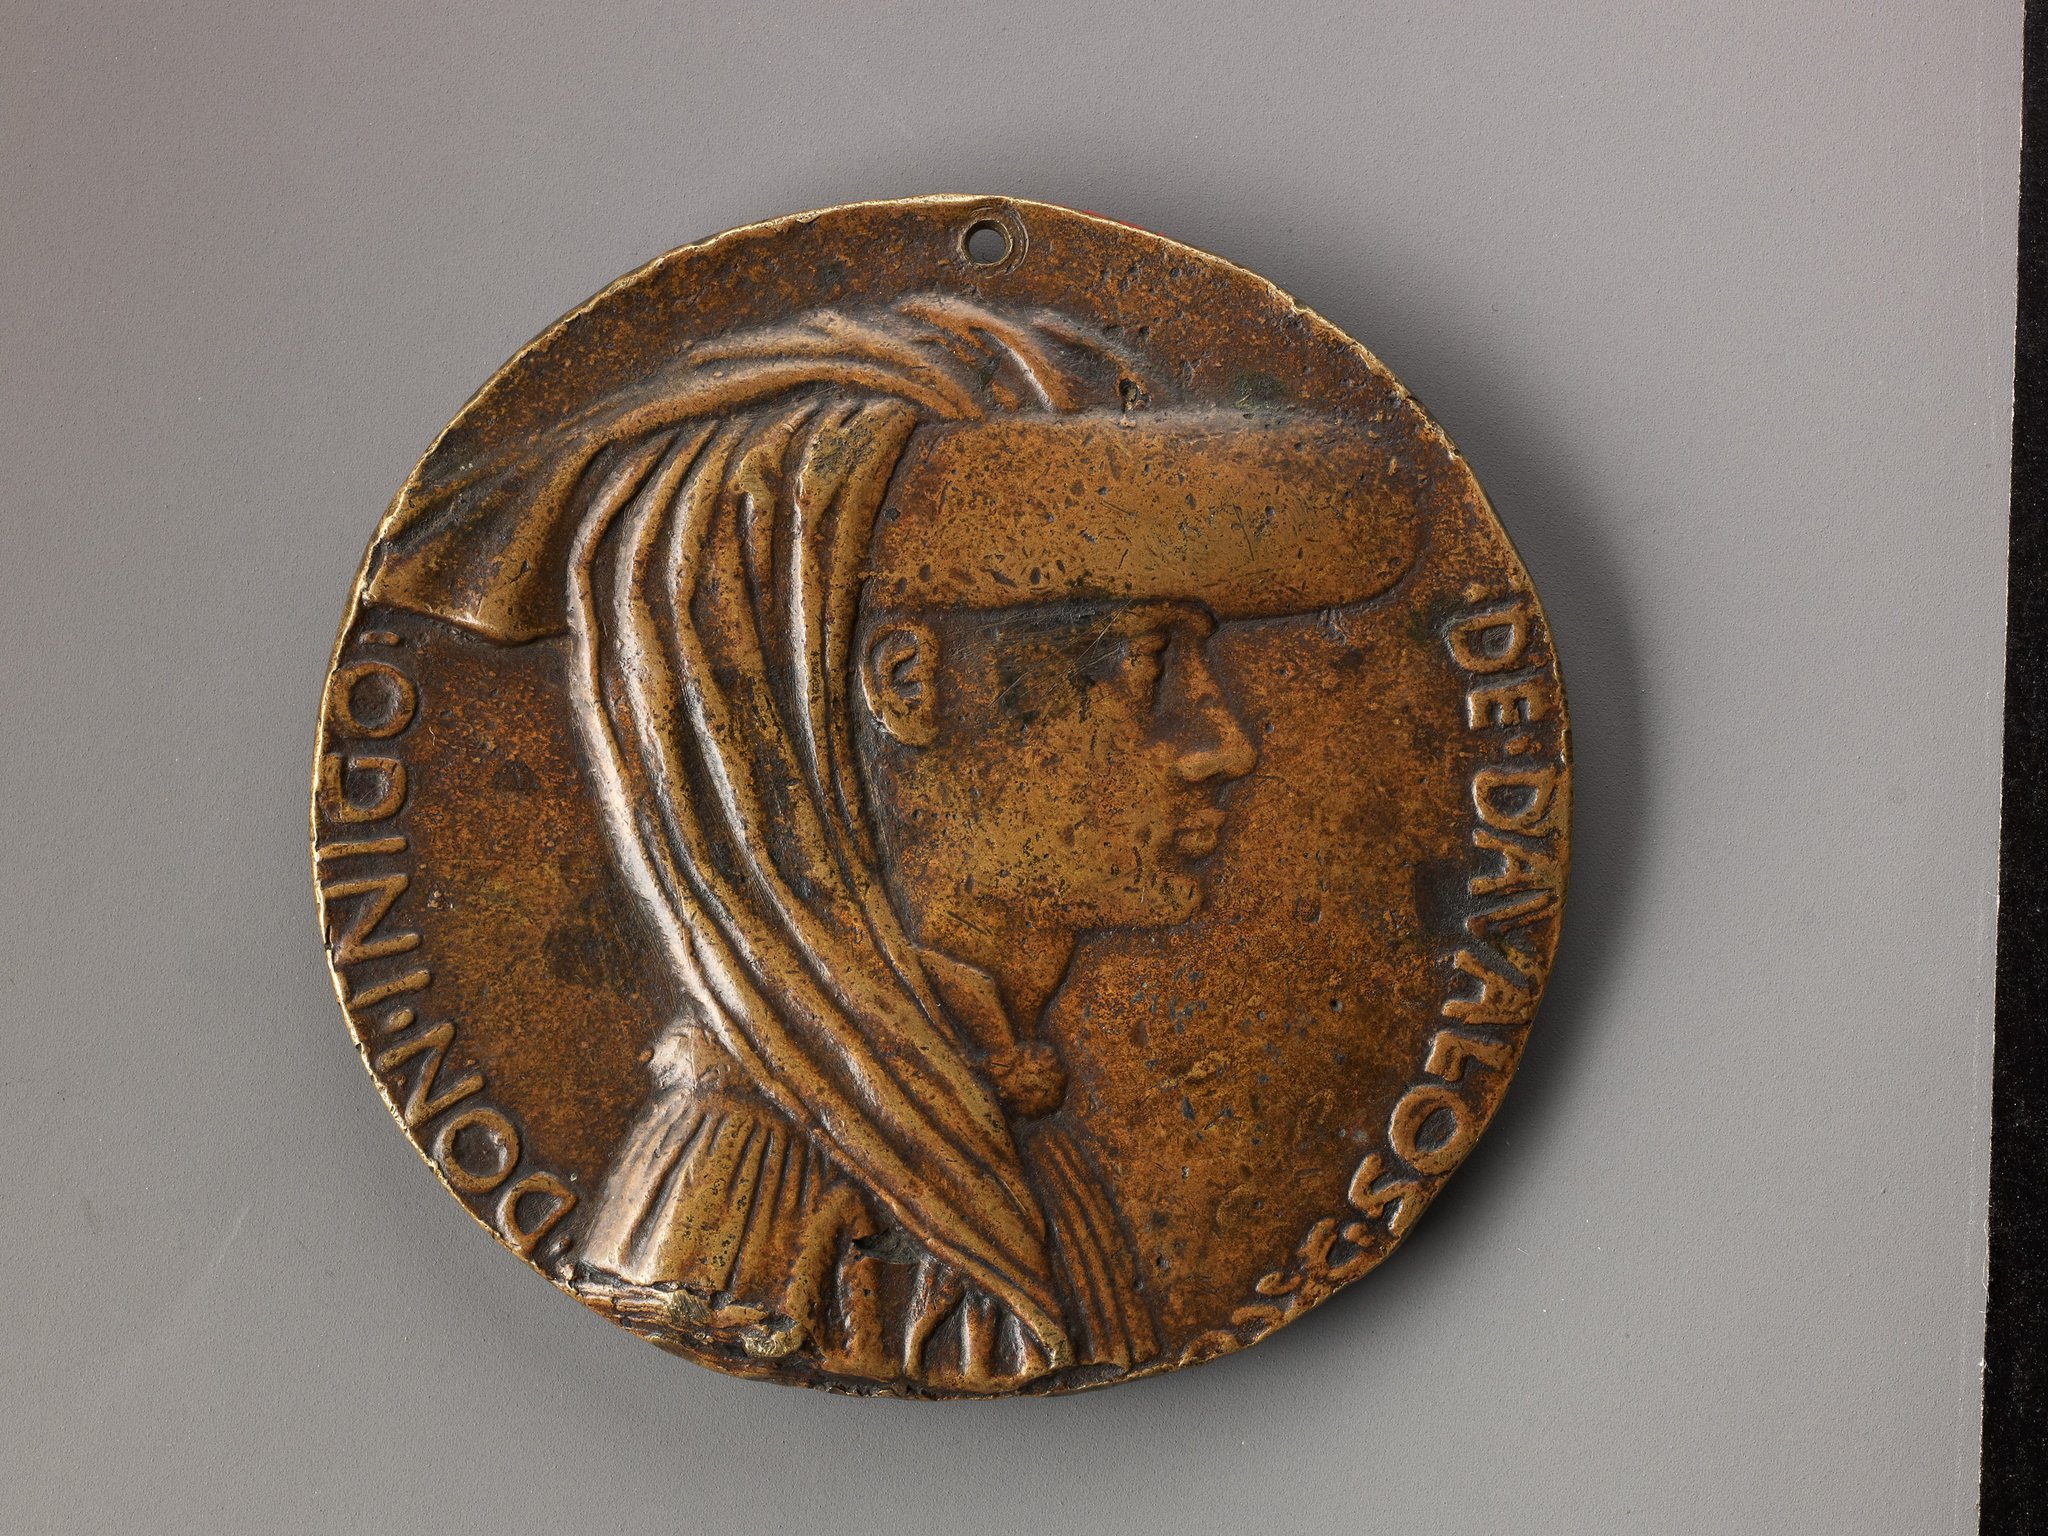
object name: medal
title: Medal: Don Inigo d'Avalos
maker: pisanello (antonio pisano)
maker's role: artist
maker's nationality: italian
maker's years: 1395-1455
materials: copper alloy, patina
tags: men,portraits